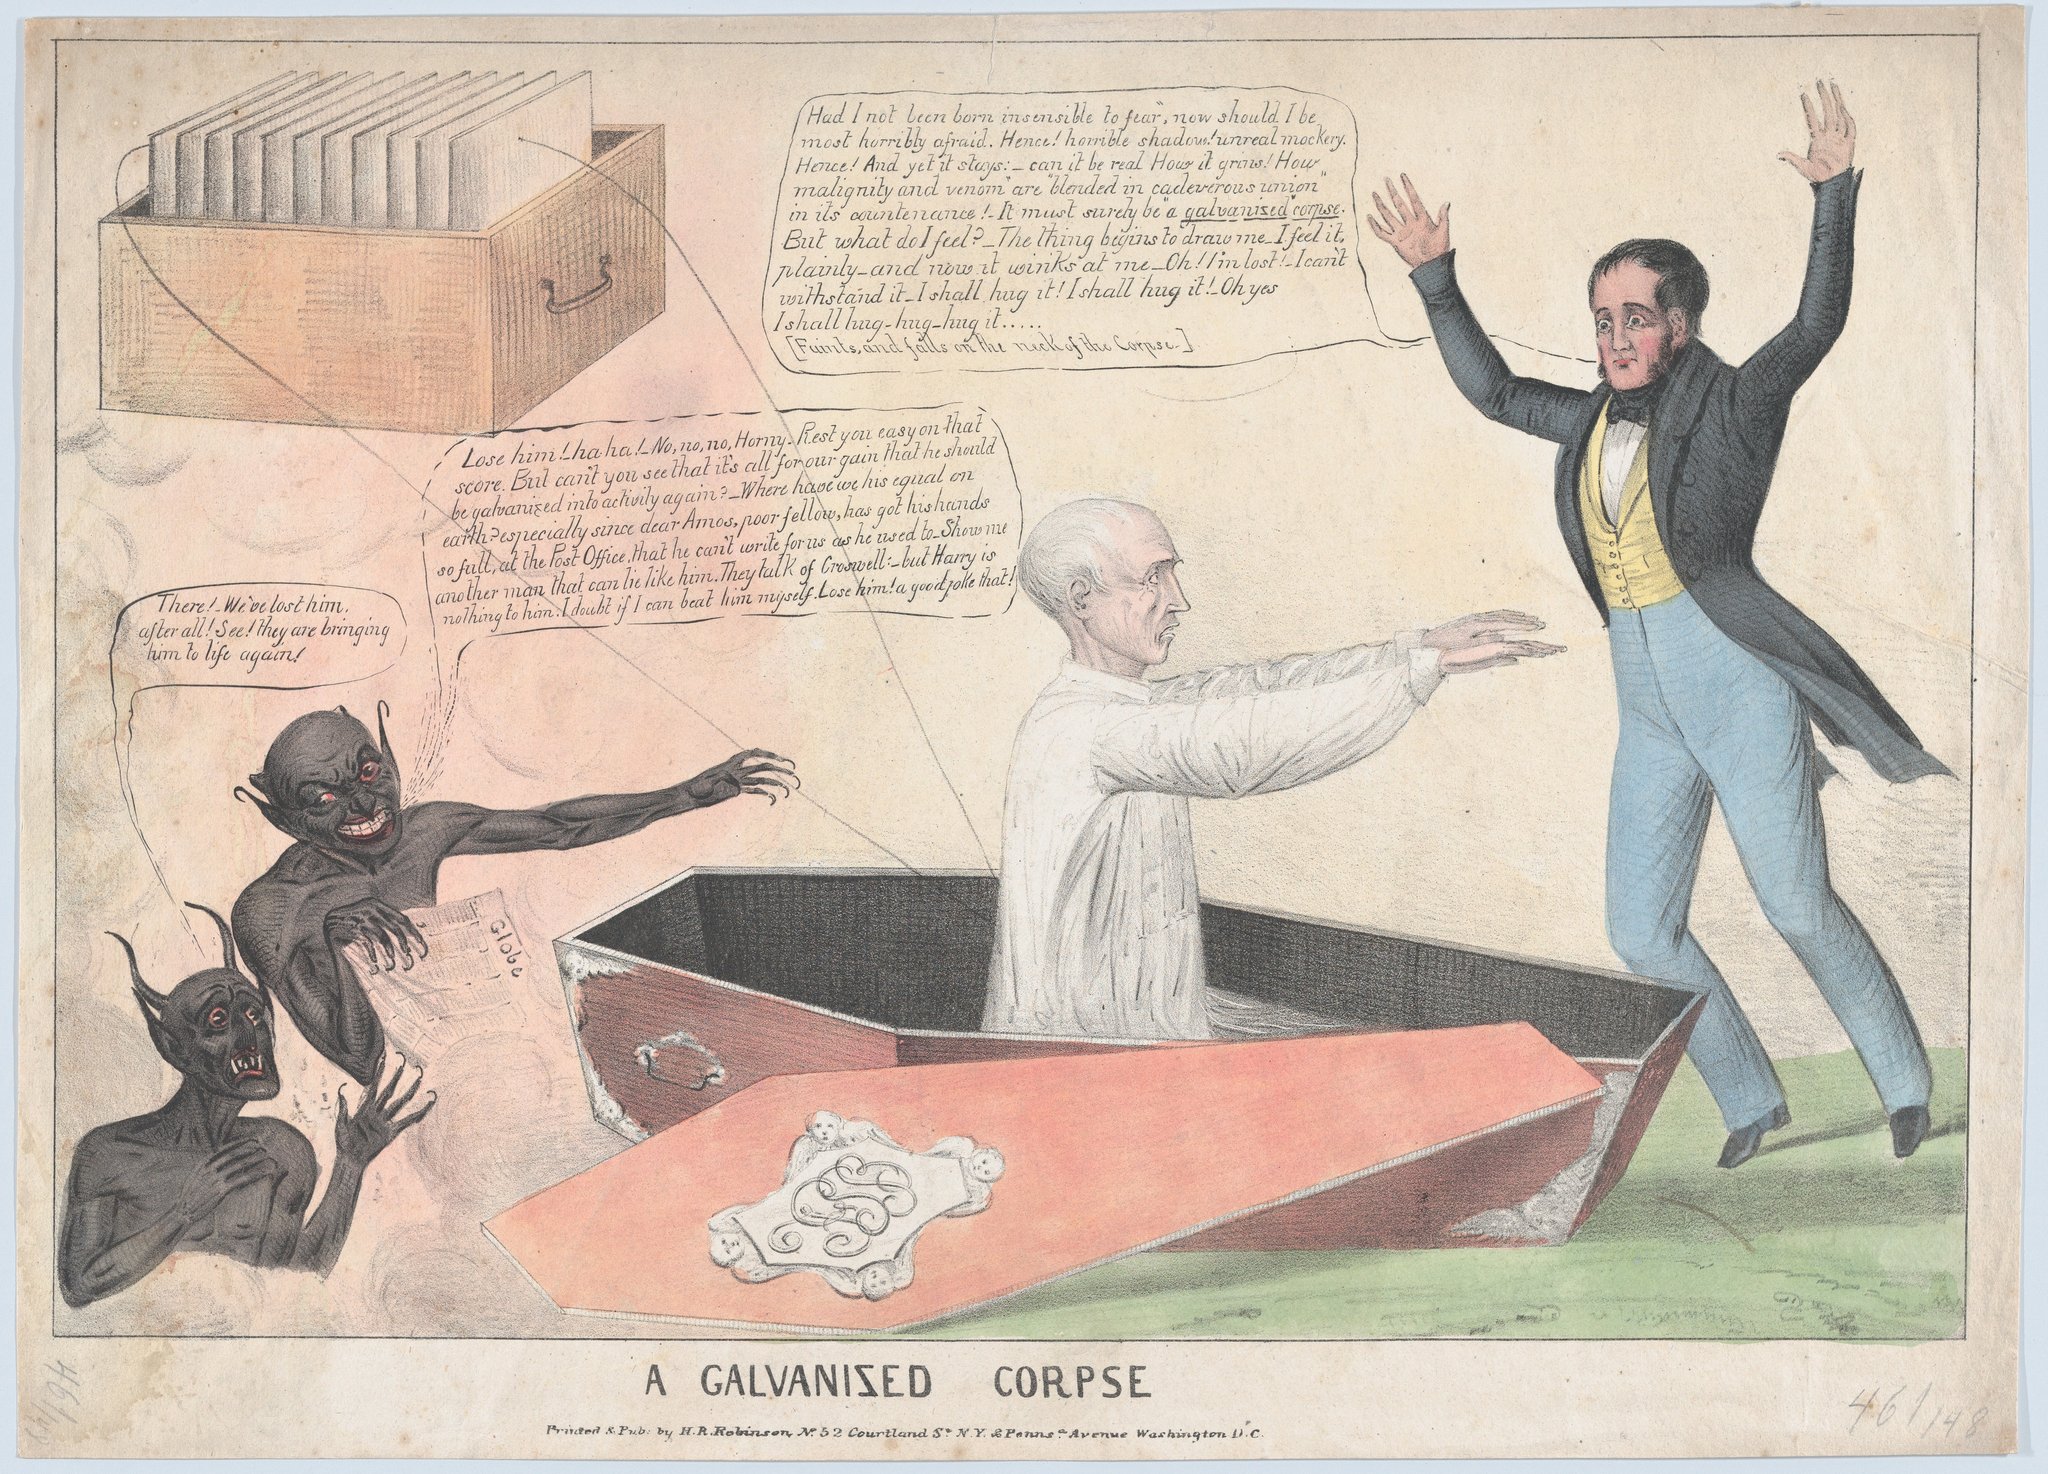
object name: print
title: A Galvanized Corpse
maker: henry r. robinson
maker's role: publisher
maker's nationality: american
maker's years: 1800-1850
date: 1836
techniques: hand coloring, lithograph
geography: new york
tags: satire,men,devil,coffins